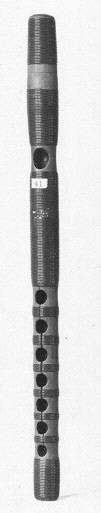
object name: no kan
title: No-Kan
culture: japanese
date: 1867-1900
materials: bamboo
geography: japan